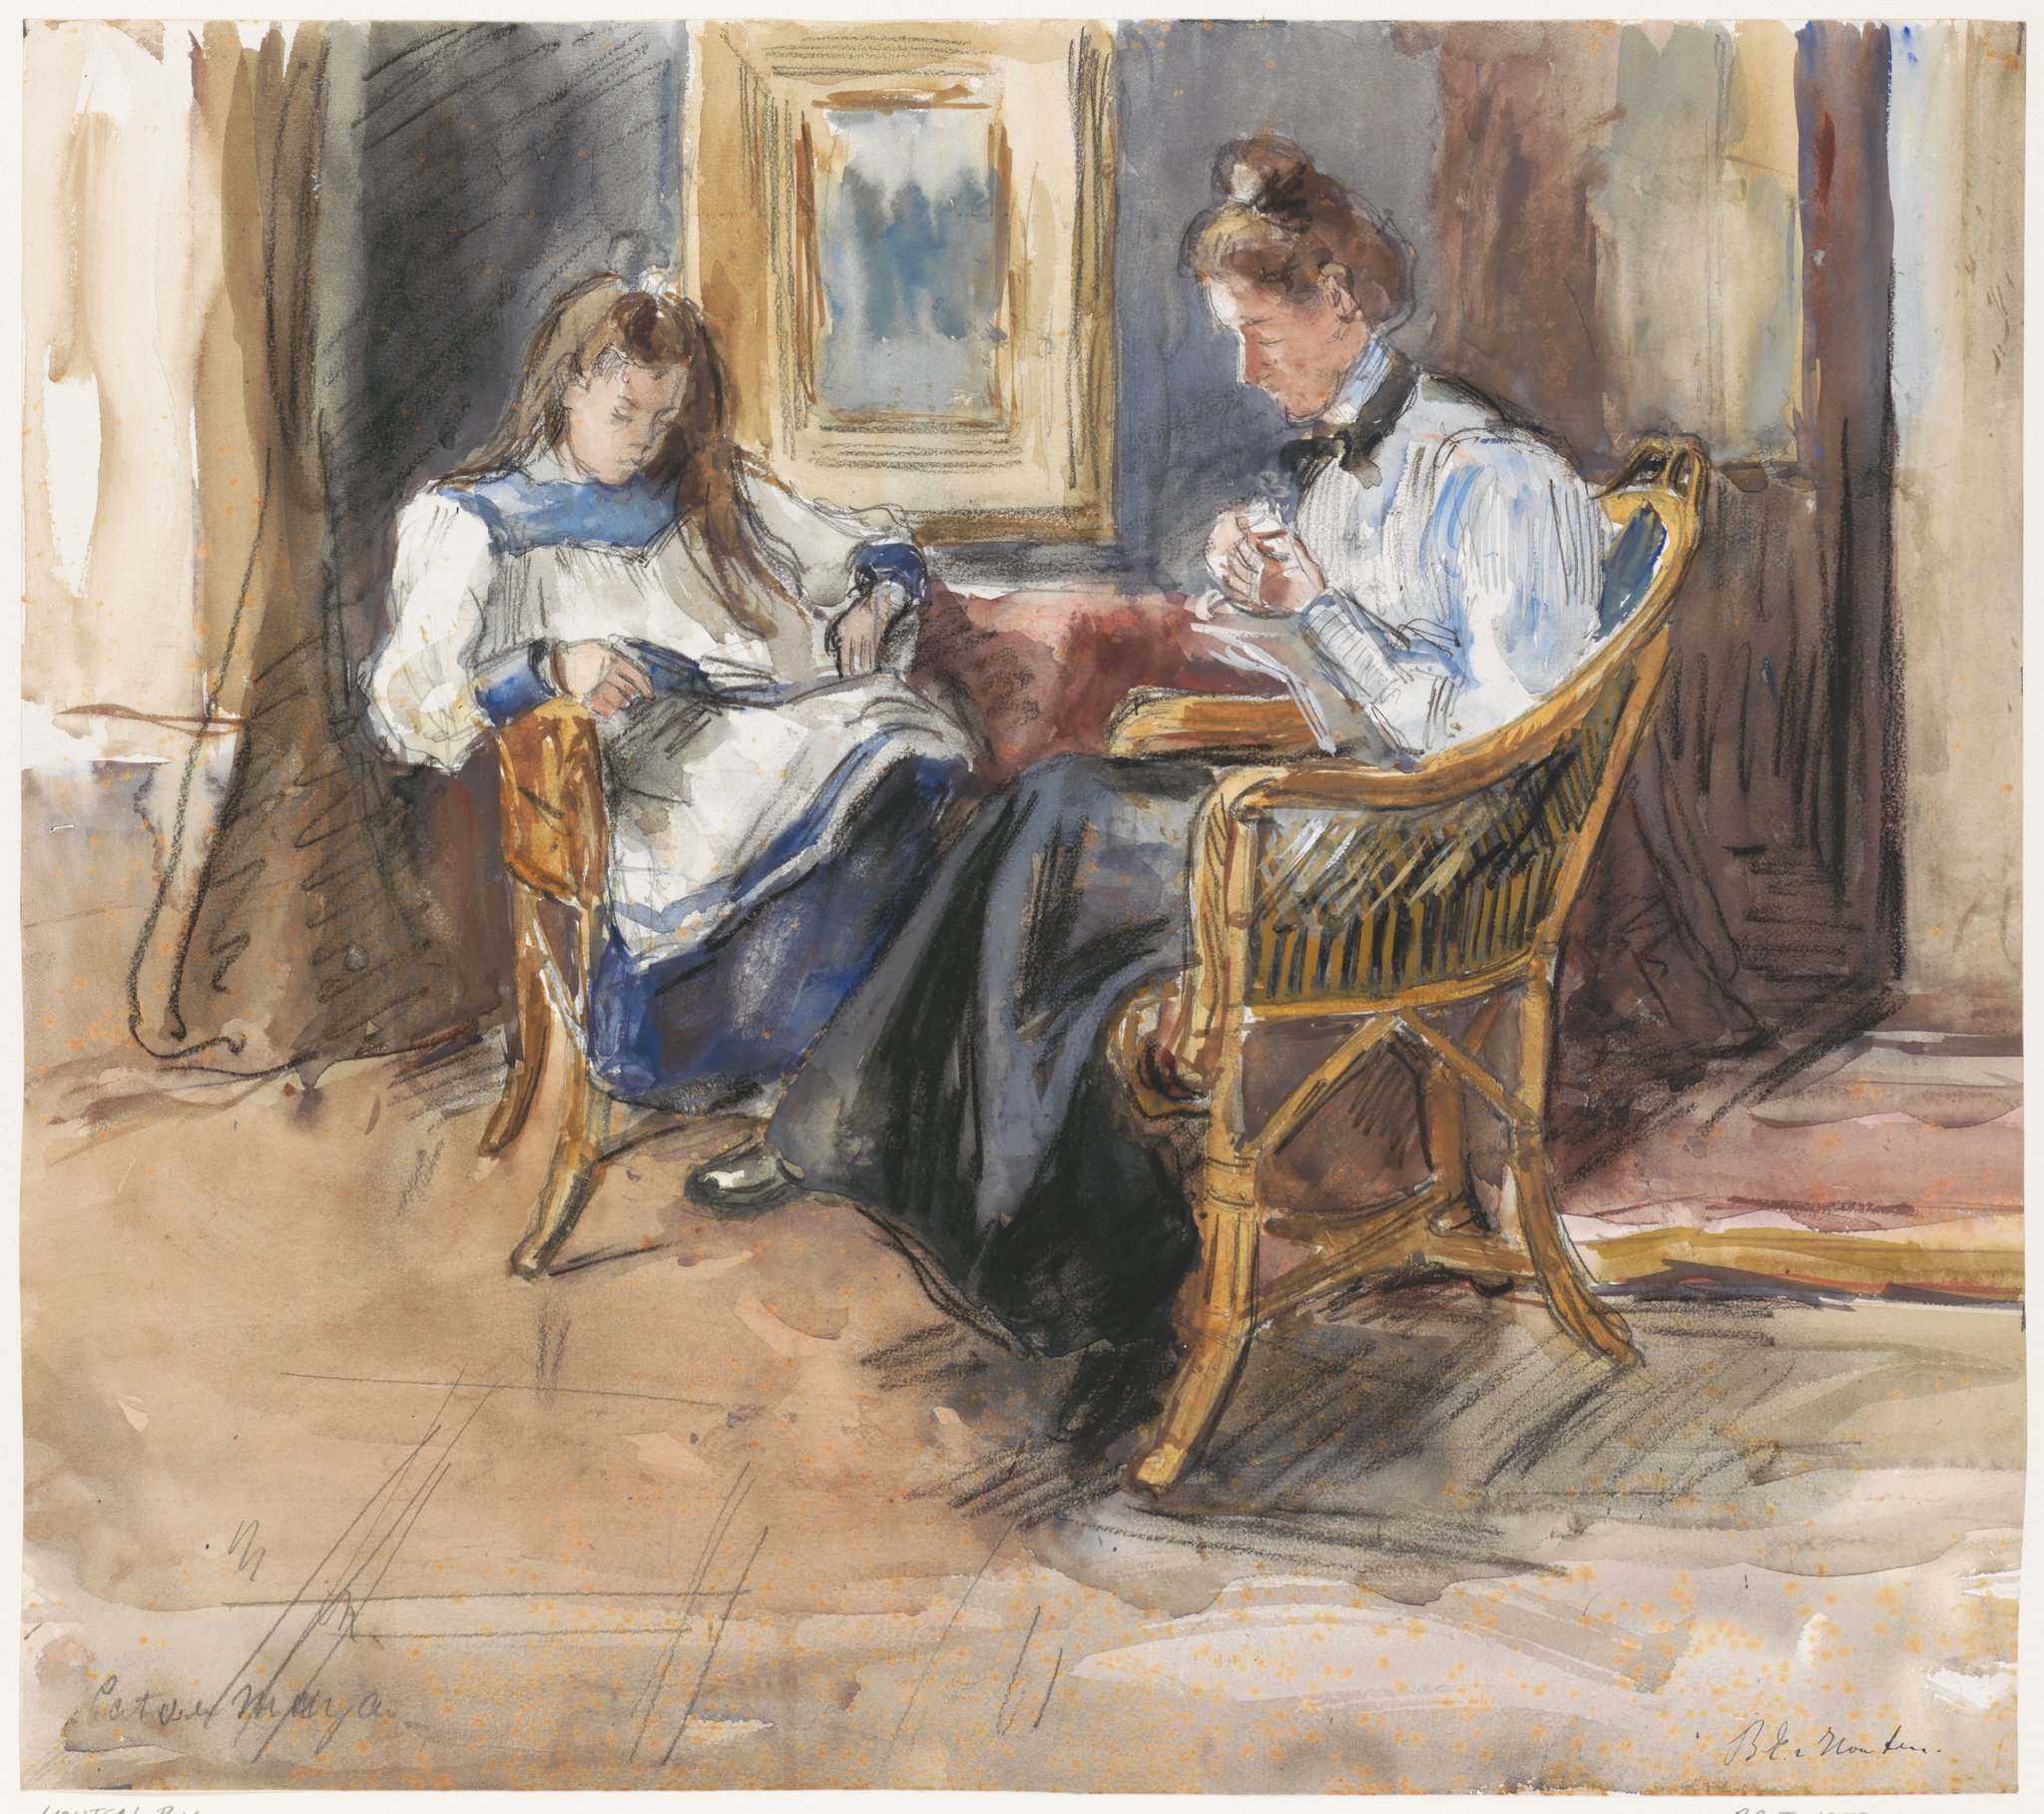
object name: drawing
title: Handwerkende Cato van Houten en lezende Marie Anna van Houten in het huis aan de Riouwstraat 6, te Den Haag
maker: barbara elisabeth van houten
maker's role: draughtsman, print maker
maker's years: 1862-1950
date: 1872-1950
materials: chalk, paper, watercolor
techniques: brush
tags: girl (child between toddler and youth), living-room, parlour, sitting-room, male sex; man, the hague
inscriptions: inscription: ‘Cato en Marjan’